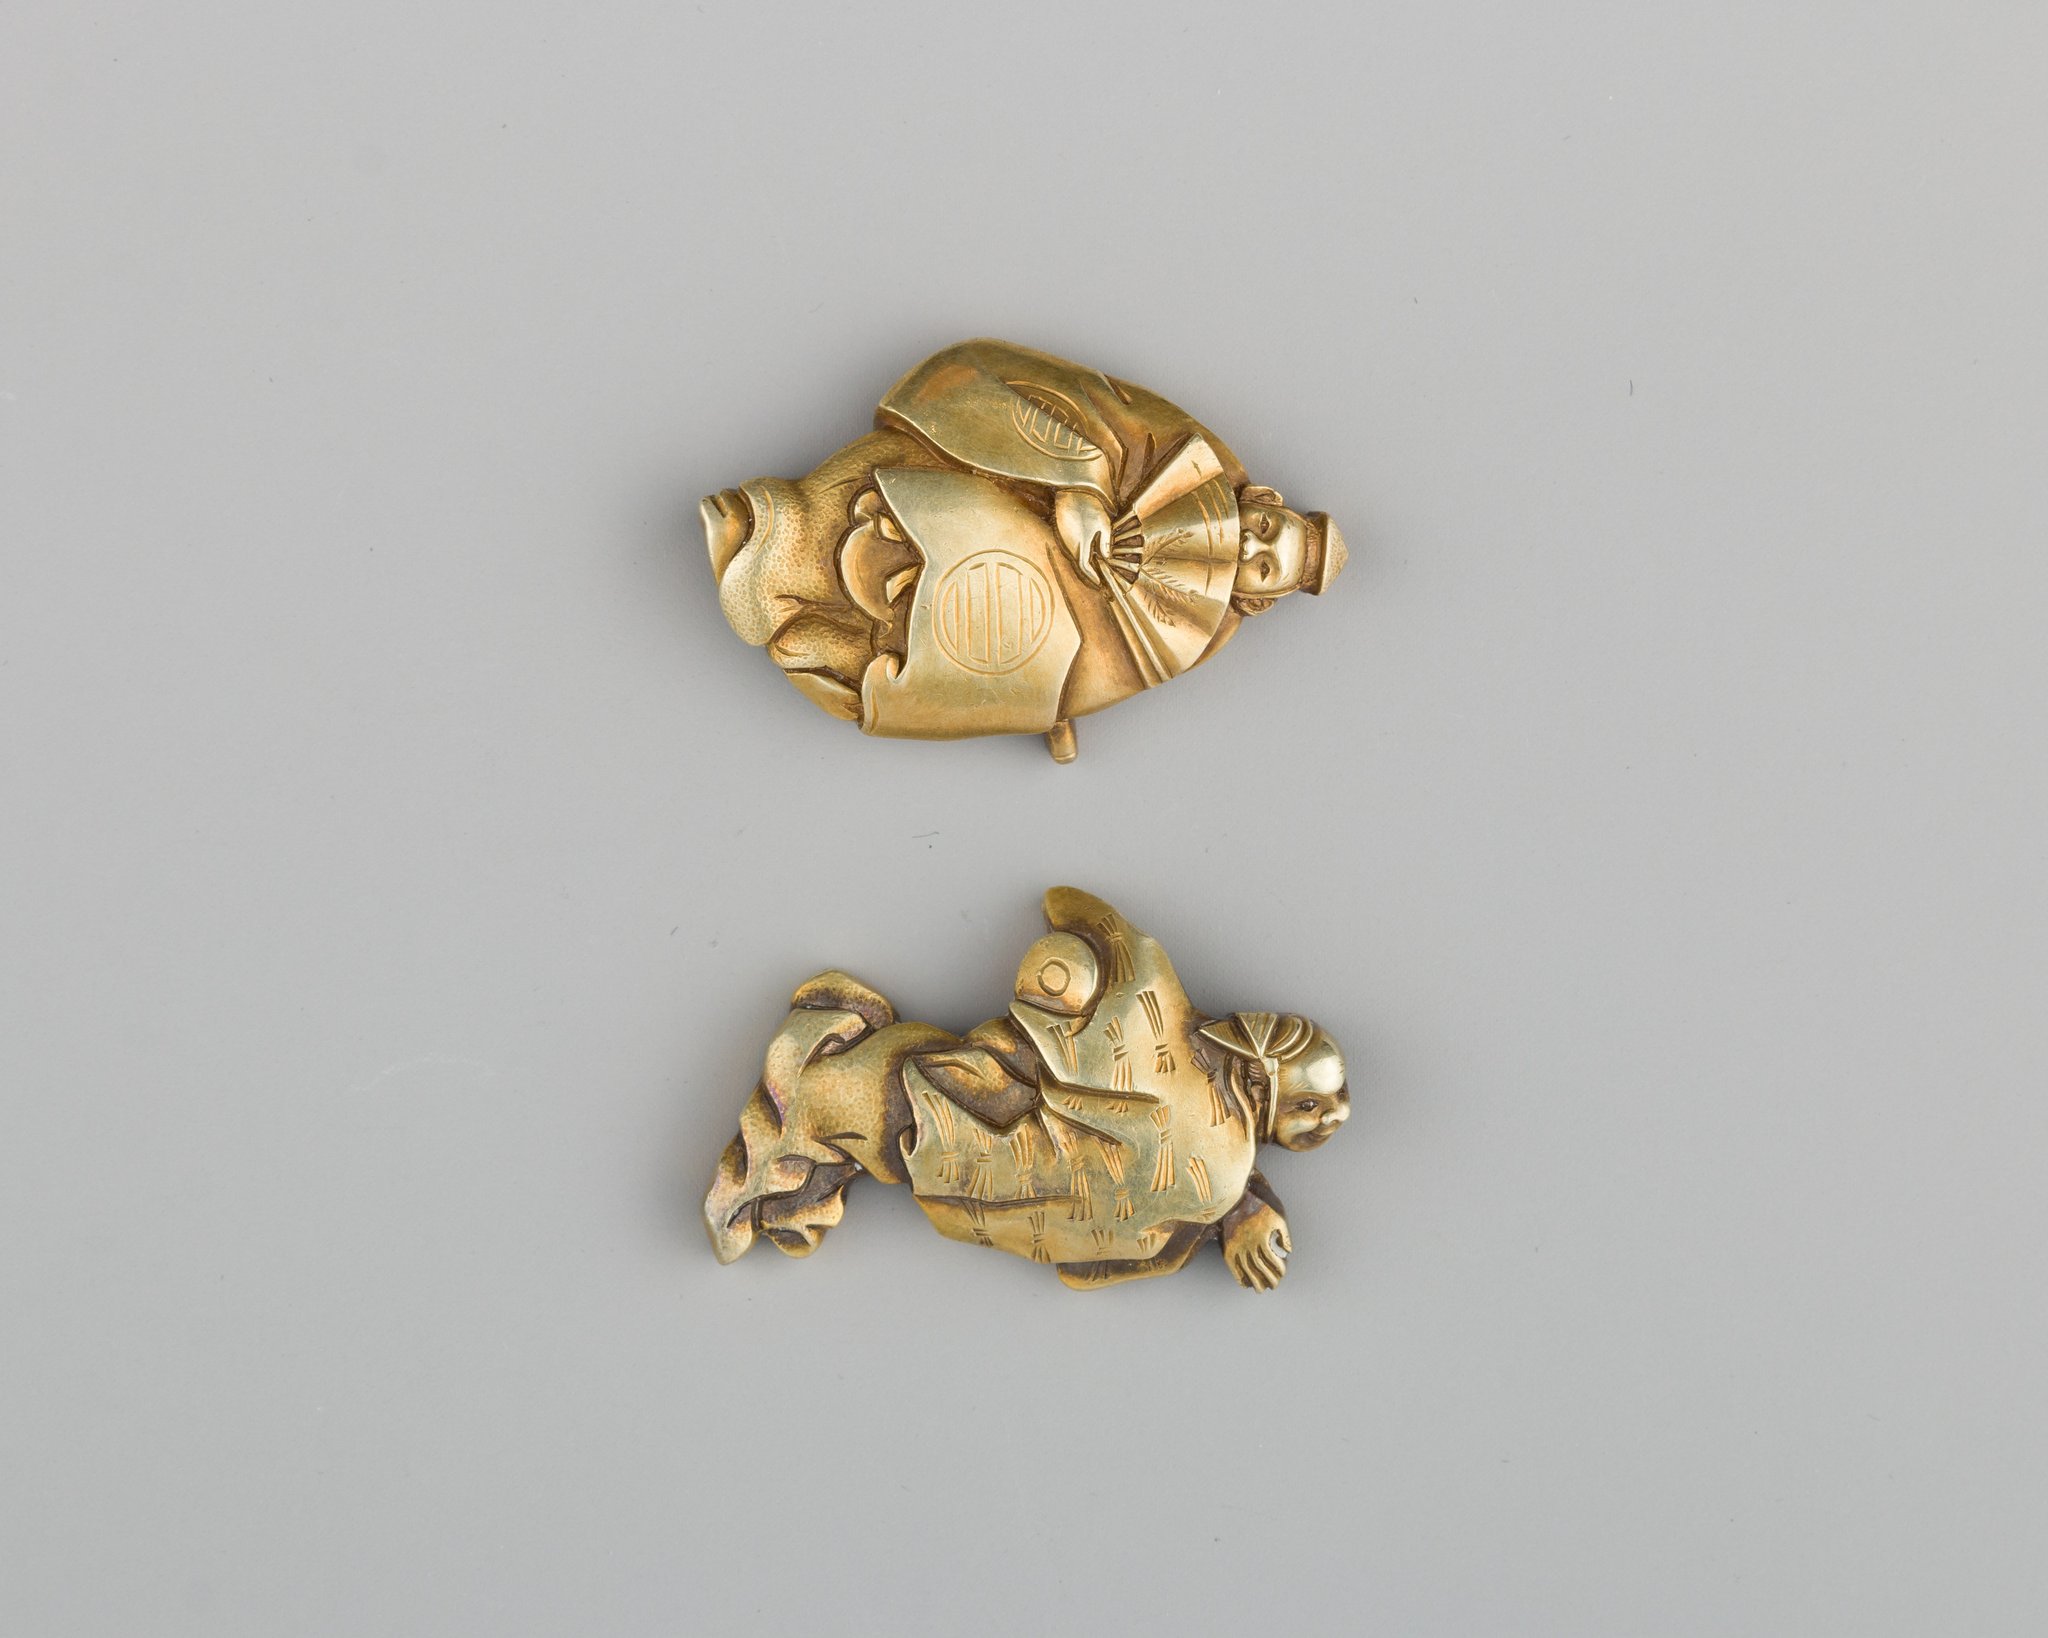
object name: pair of sword grip ornament menuki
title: Pair of Sword-Grip Ornaments (Menuki)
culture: japanese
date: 1701-1800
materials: gold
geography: japan